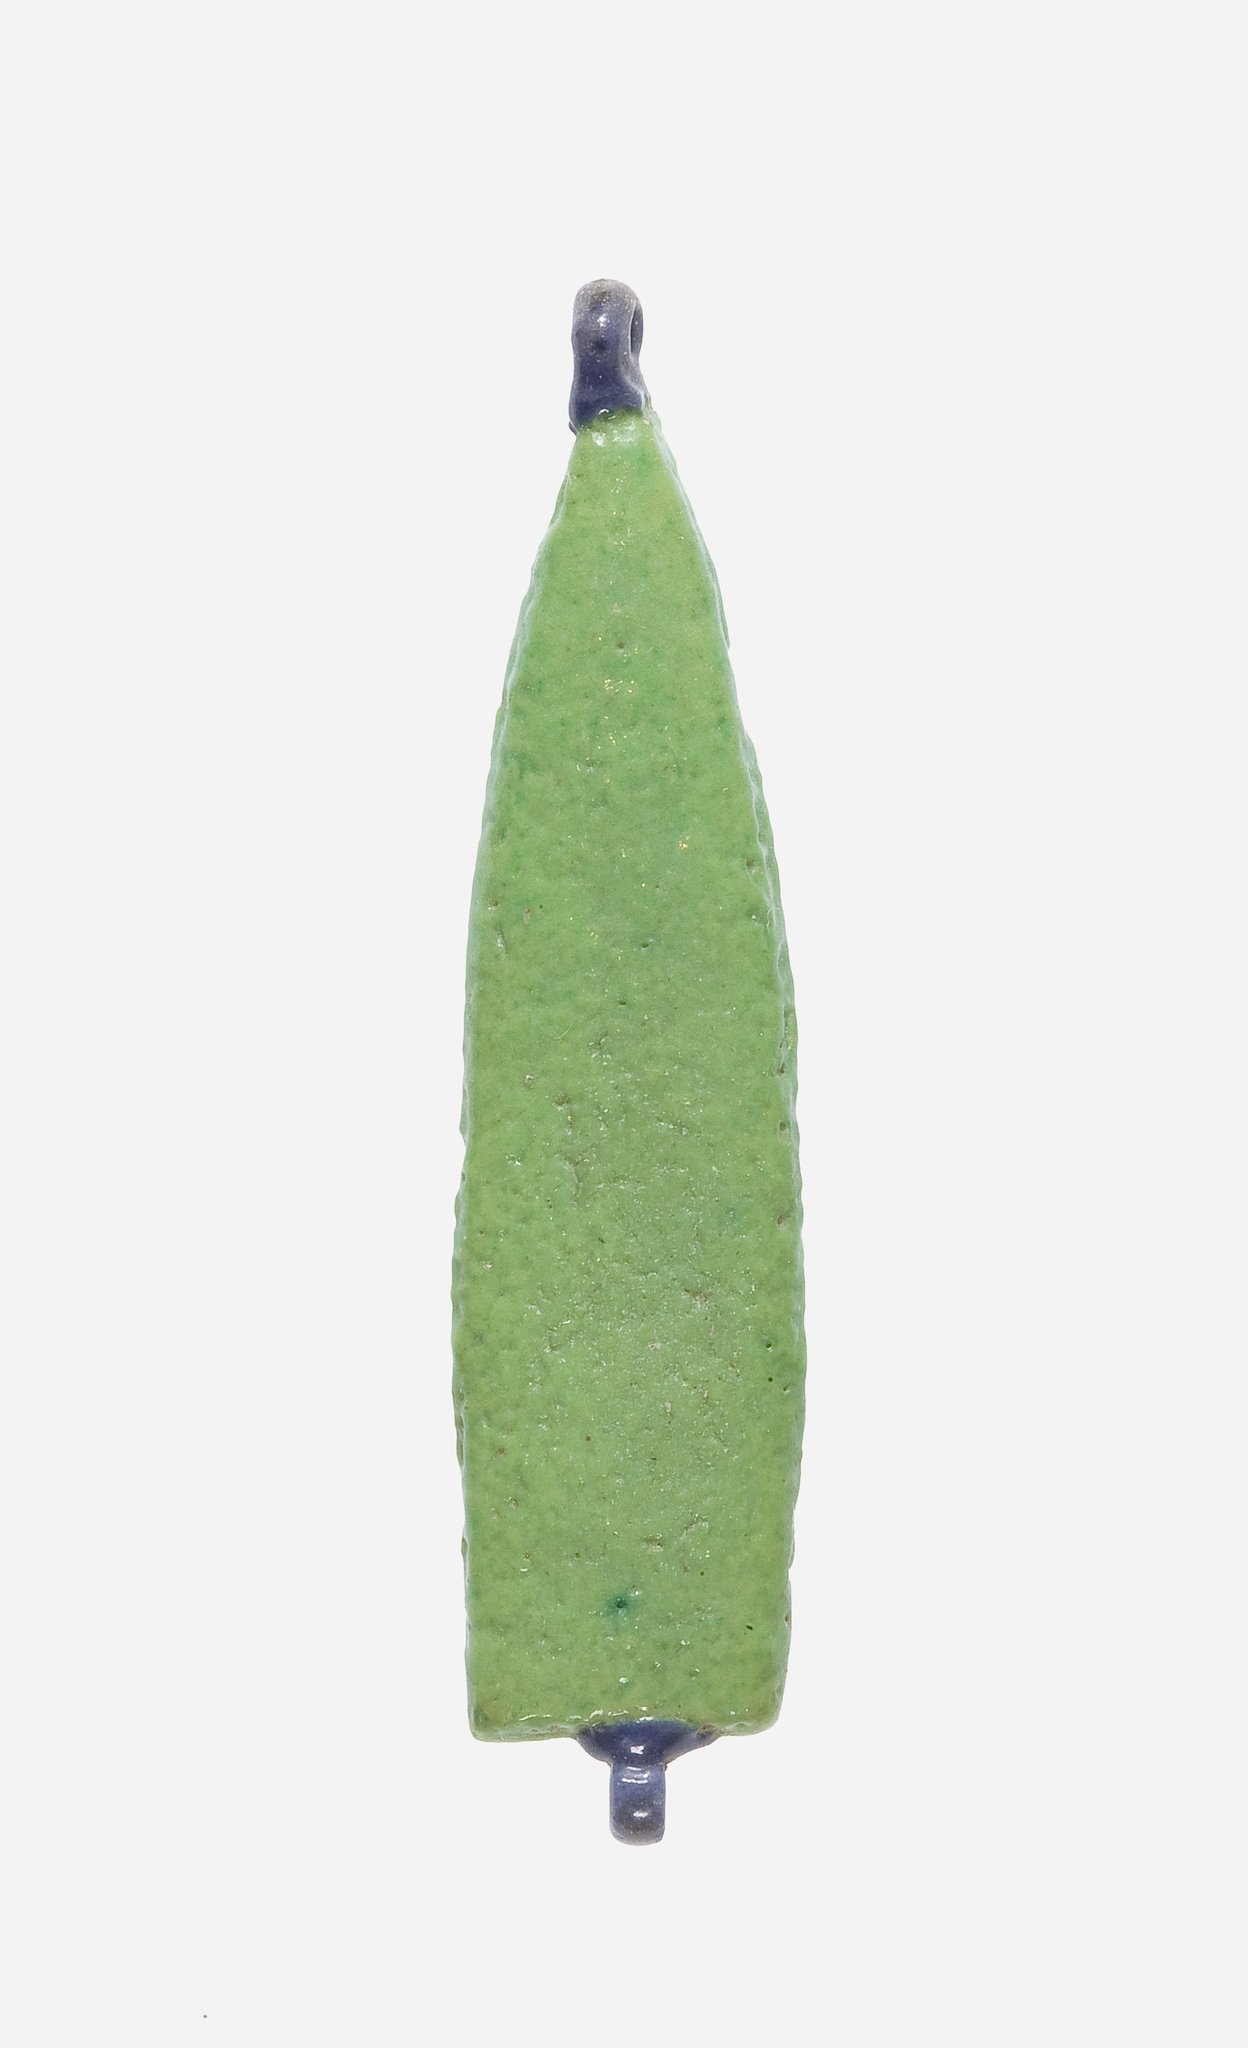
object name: bead, lotus sepal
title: Bead in the Form of a Lotus Sepal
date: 1390-1352 BCE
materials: faience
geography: egypt